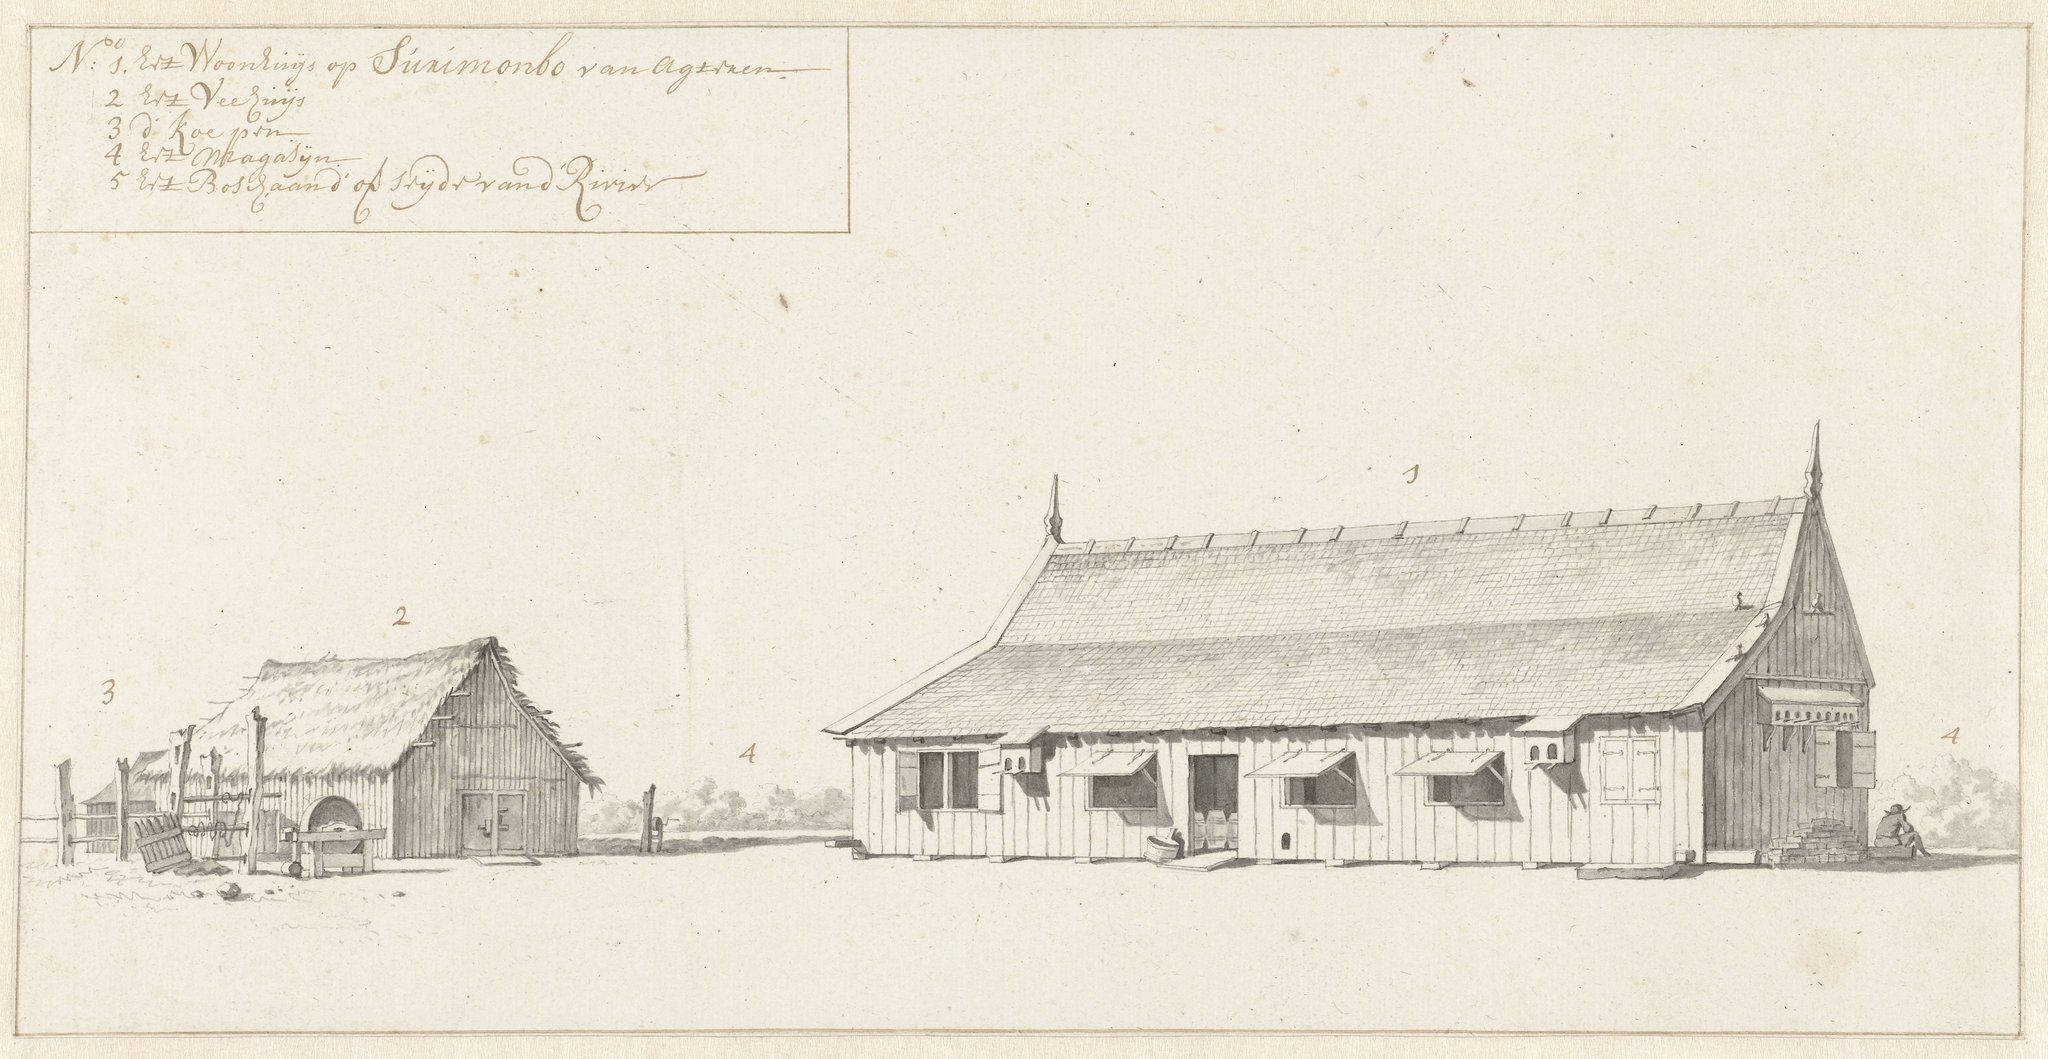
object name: drawing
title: Residence and a Barn on the Surimombo Plantation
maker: dirk valkenburg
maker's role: draughtsman, painter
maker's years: 1675-1721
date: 1708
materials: chalk, ink, paper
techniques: brush, pen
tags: plantation, rural housing, e.g. country-house, villa, cottage, suriname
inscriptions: : ‘N0 1 het Woonhuijs op Surimonbo van Agteren 2 het Vee huijs 3 d’Koe pen 4 het Magasijn 5 het Boschaan d’ op sijde van d’Rivier’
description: Drawings of the Palmeneribo, Waterland and Surimombo Plantations. With the viewing instructions that Valken burg noted on his drawings, Witsen was able to take a virtual walk around his plantations. There are hardly any people in the drawings, except possibly Valkenburg himself on the doorstep of the residence on Surimombo. The artist seems to have a particular eye for the buildings and for the sluice, which was important to regulate the water level. The sugar cane fields are also missing. For Witsen, Valkenburg was not only a link between the two worlds, but also a filter.